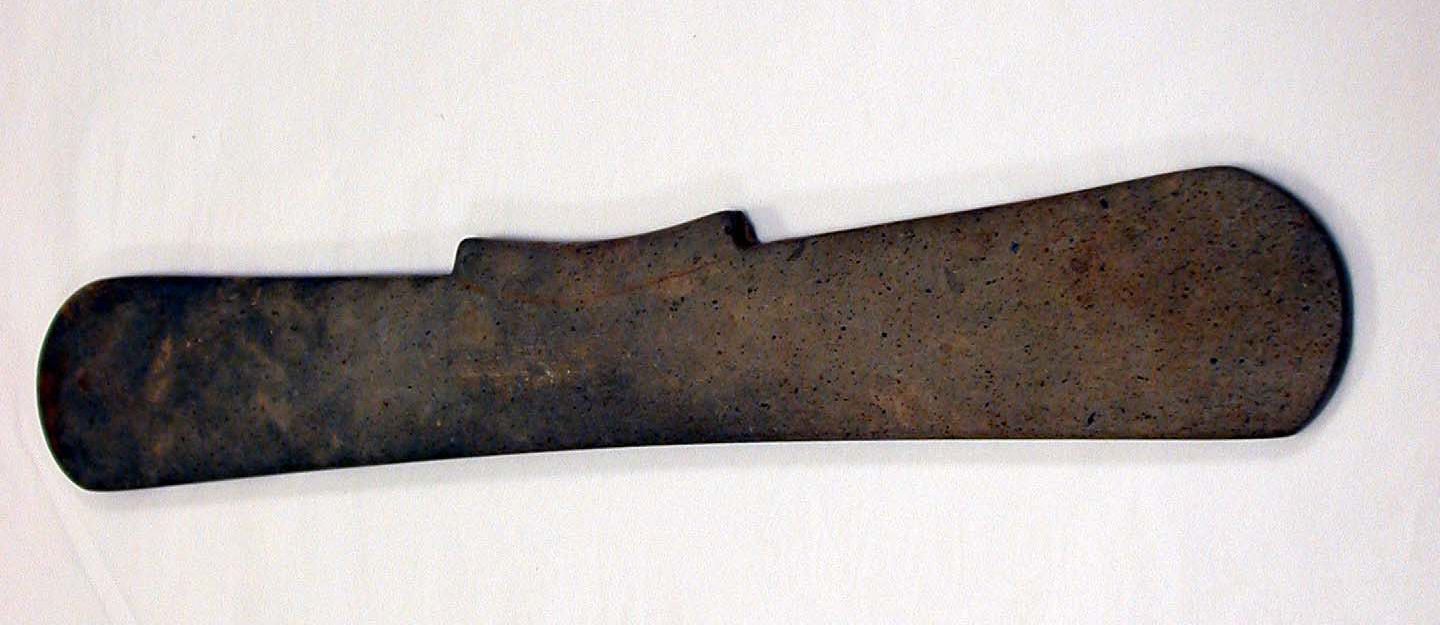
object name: pendant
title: Winged Pendant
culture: tairona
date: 901-1600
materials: stone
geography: colombia